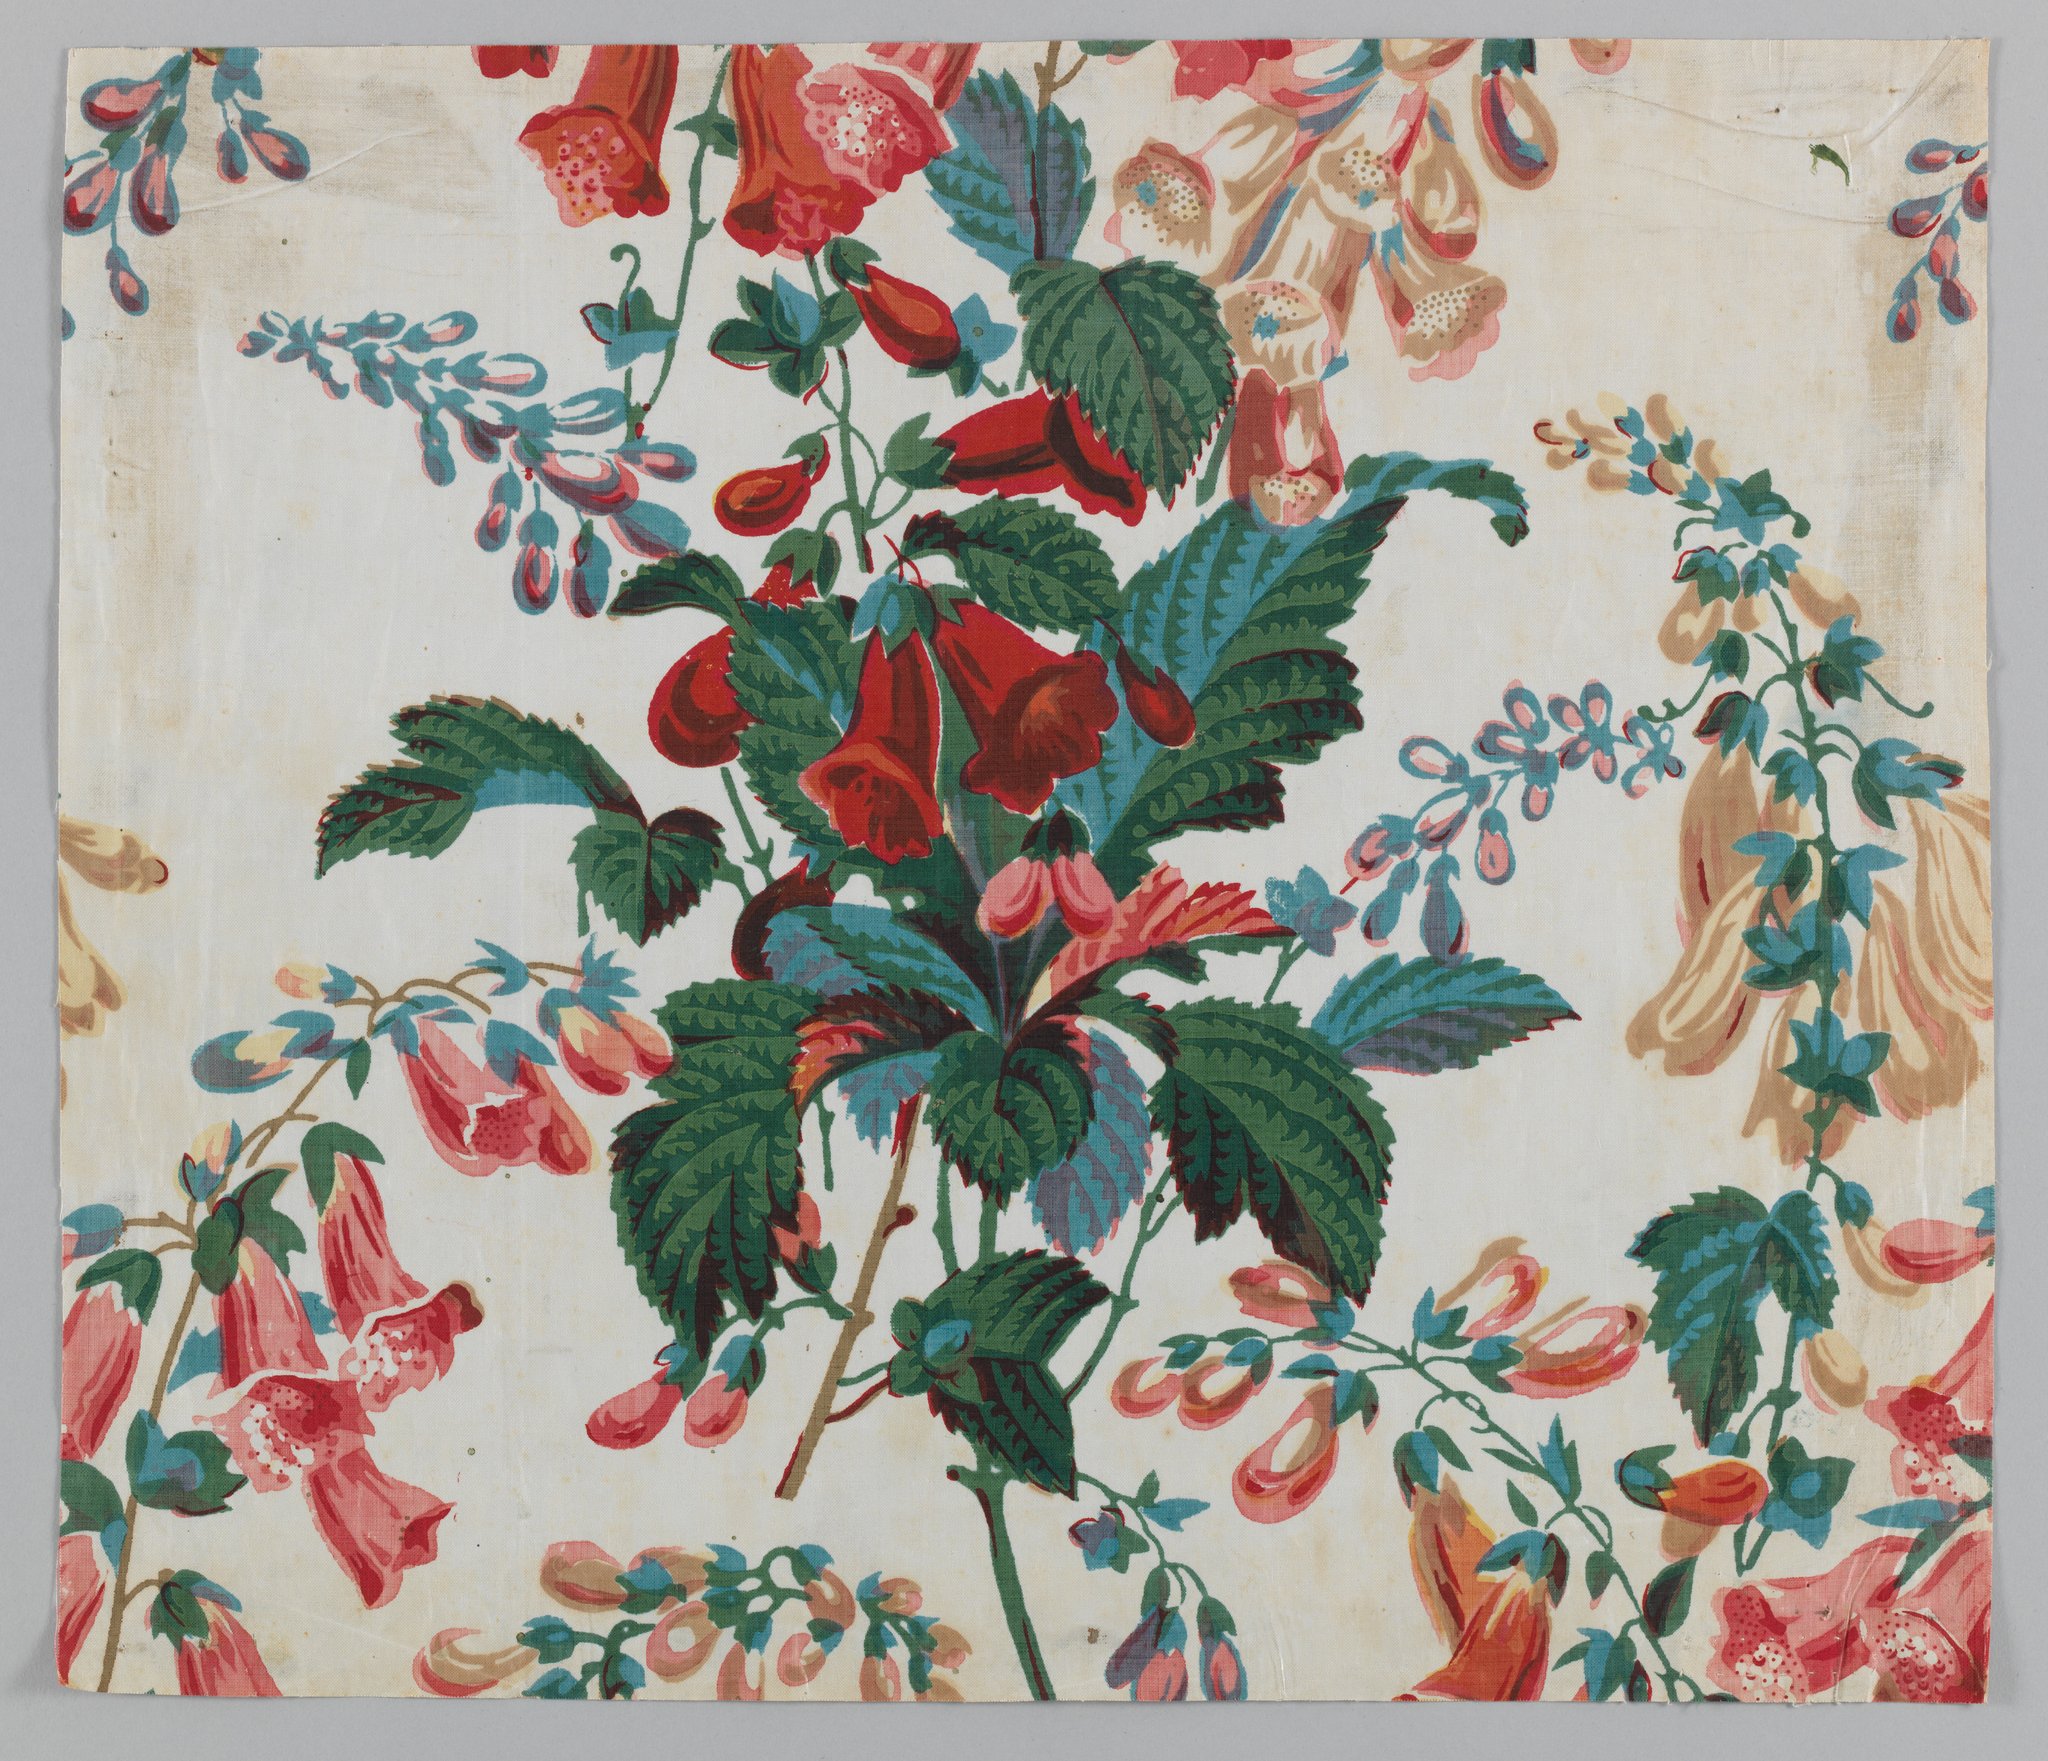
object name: piece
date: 1801-1900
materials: cotton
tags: flowers